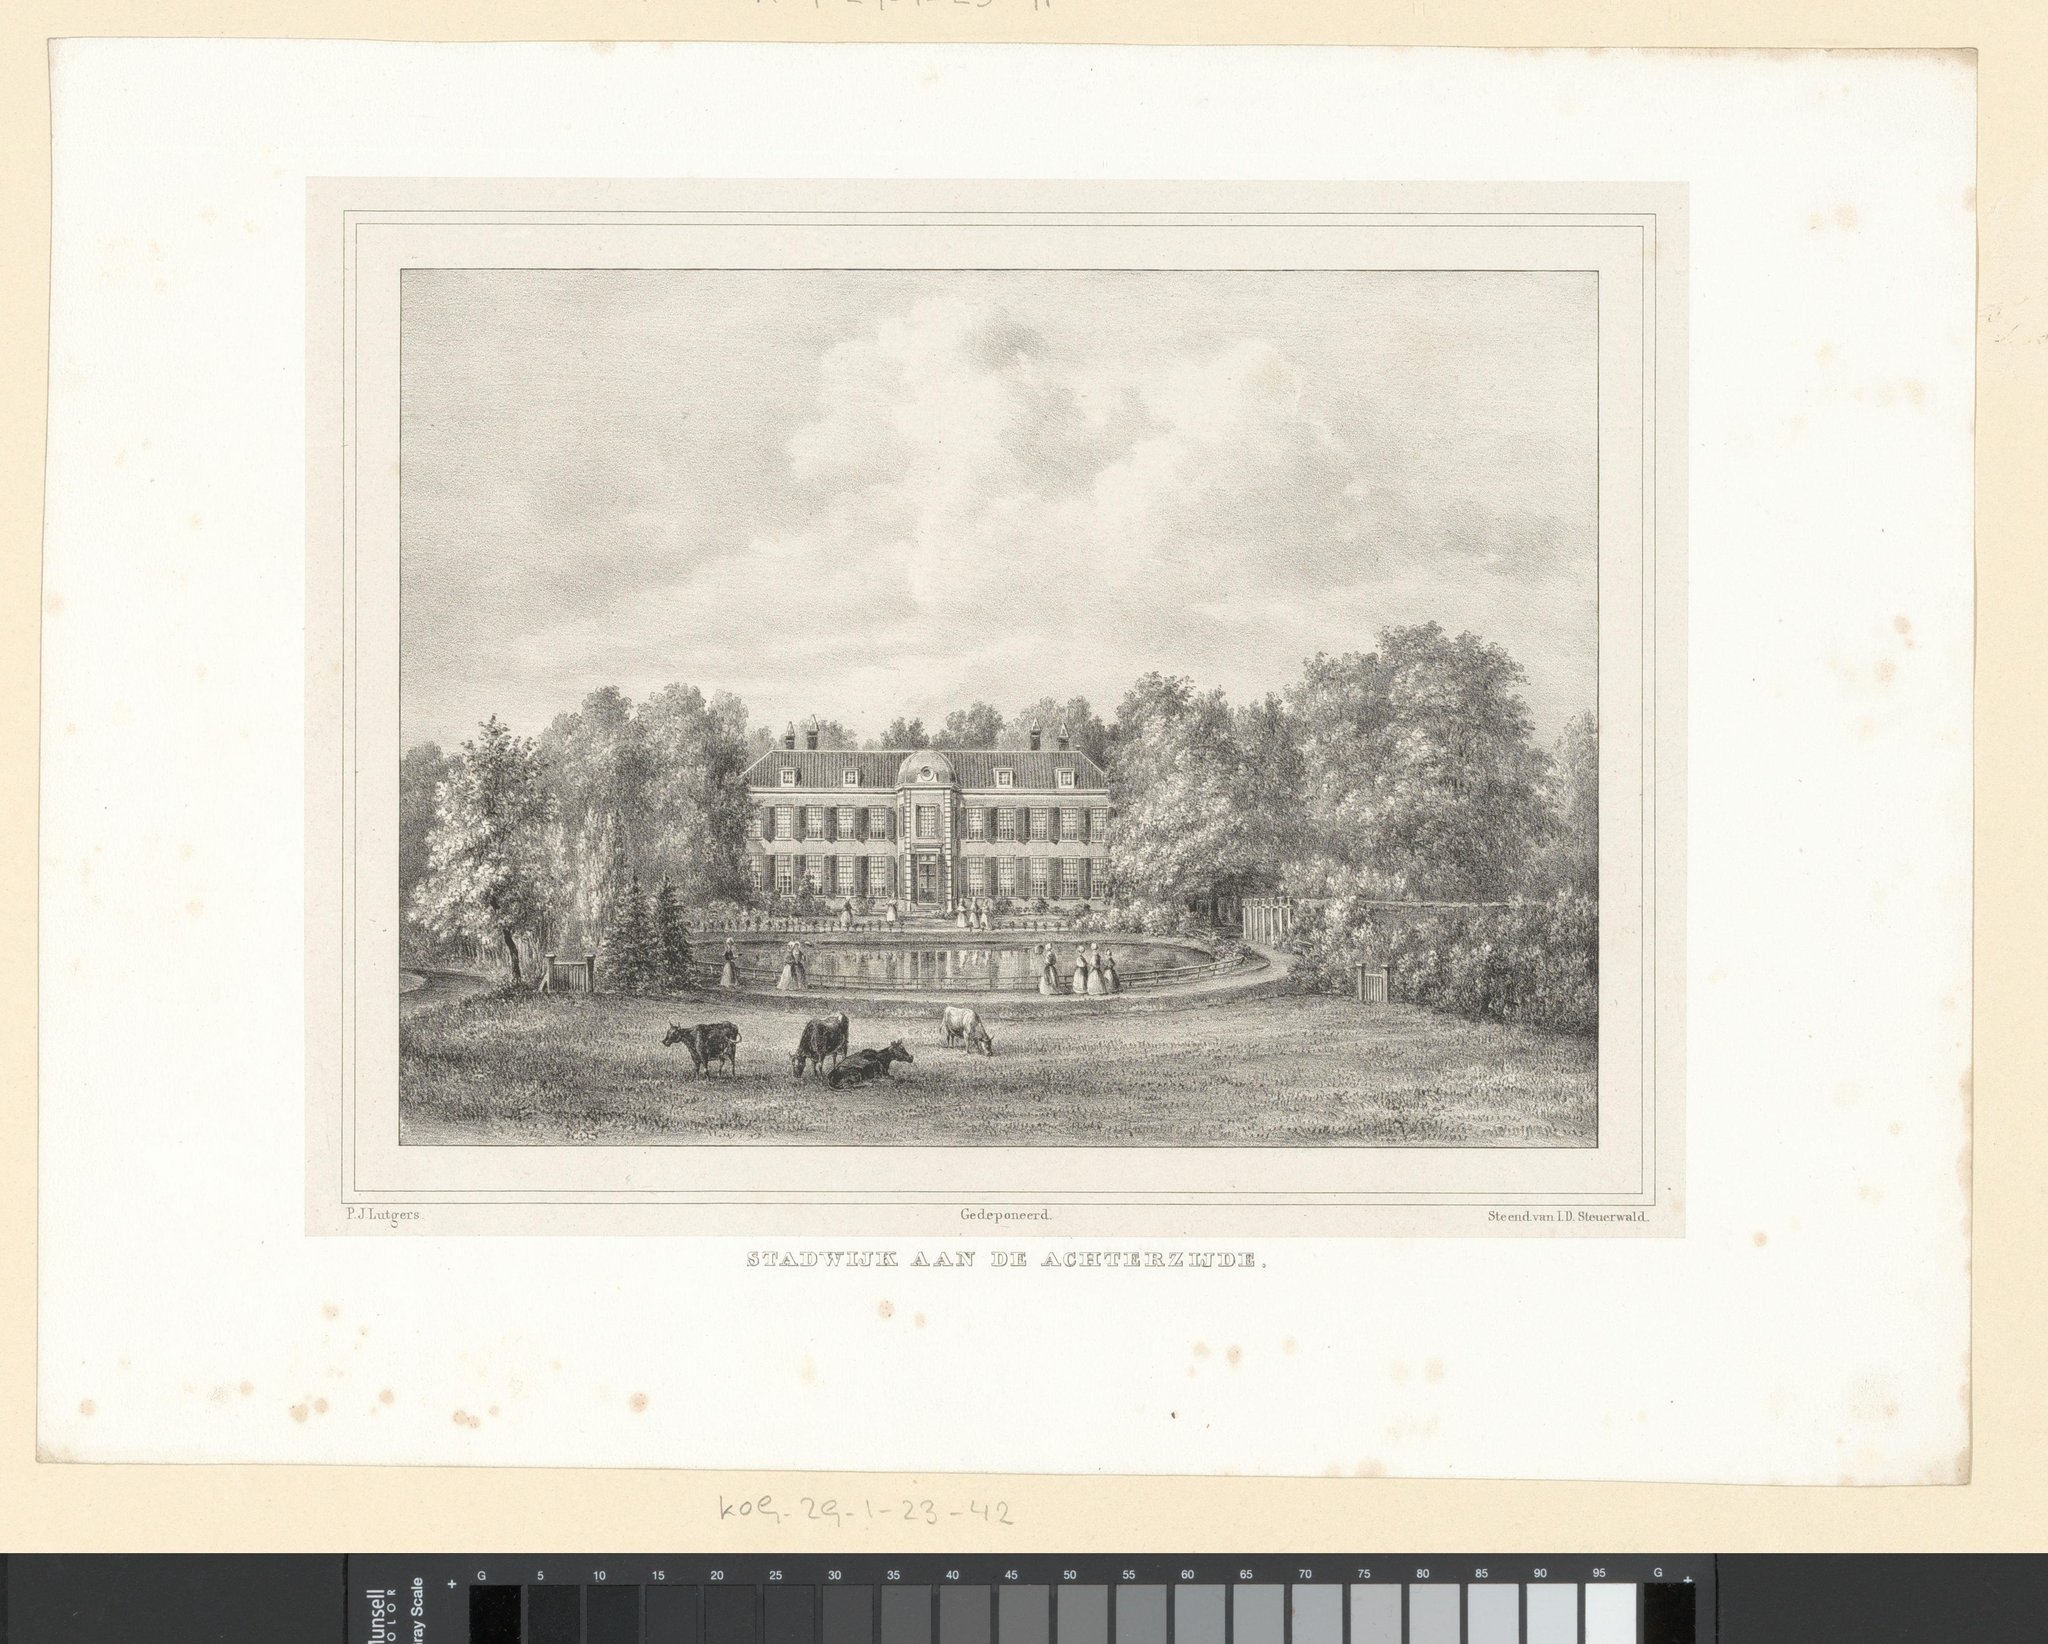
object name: print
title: Gezicht op de achterzijde van de buitenplaats Stadwijk te Voorschoten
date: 1855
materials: paper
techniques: lithograph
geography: the hague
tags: trees, farm or solitary house in landscape, voorschoten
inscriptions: stamp, : ‘Gedeponeerd’, stamp, collector's mark: Lugt 1641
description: Onderwerpsrubrieken binnen de Atlas Zeden en Gewoonten: Zeden en Gewoonten in Engeren Zin, De Woning. Kastelen en buitenplaatsen. Holland.